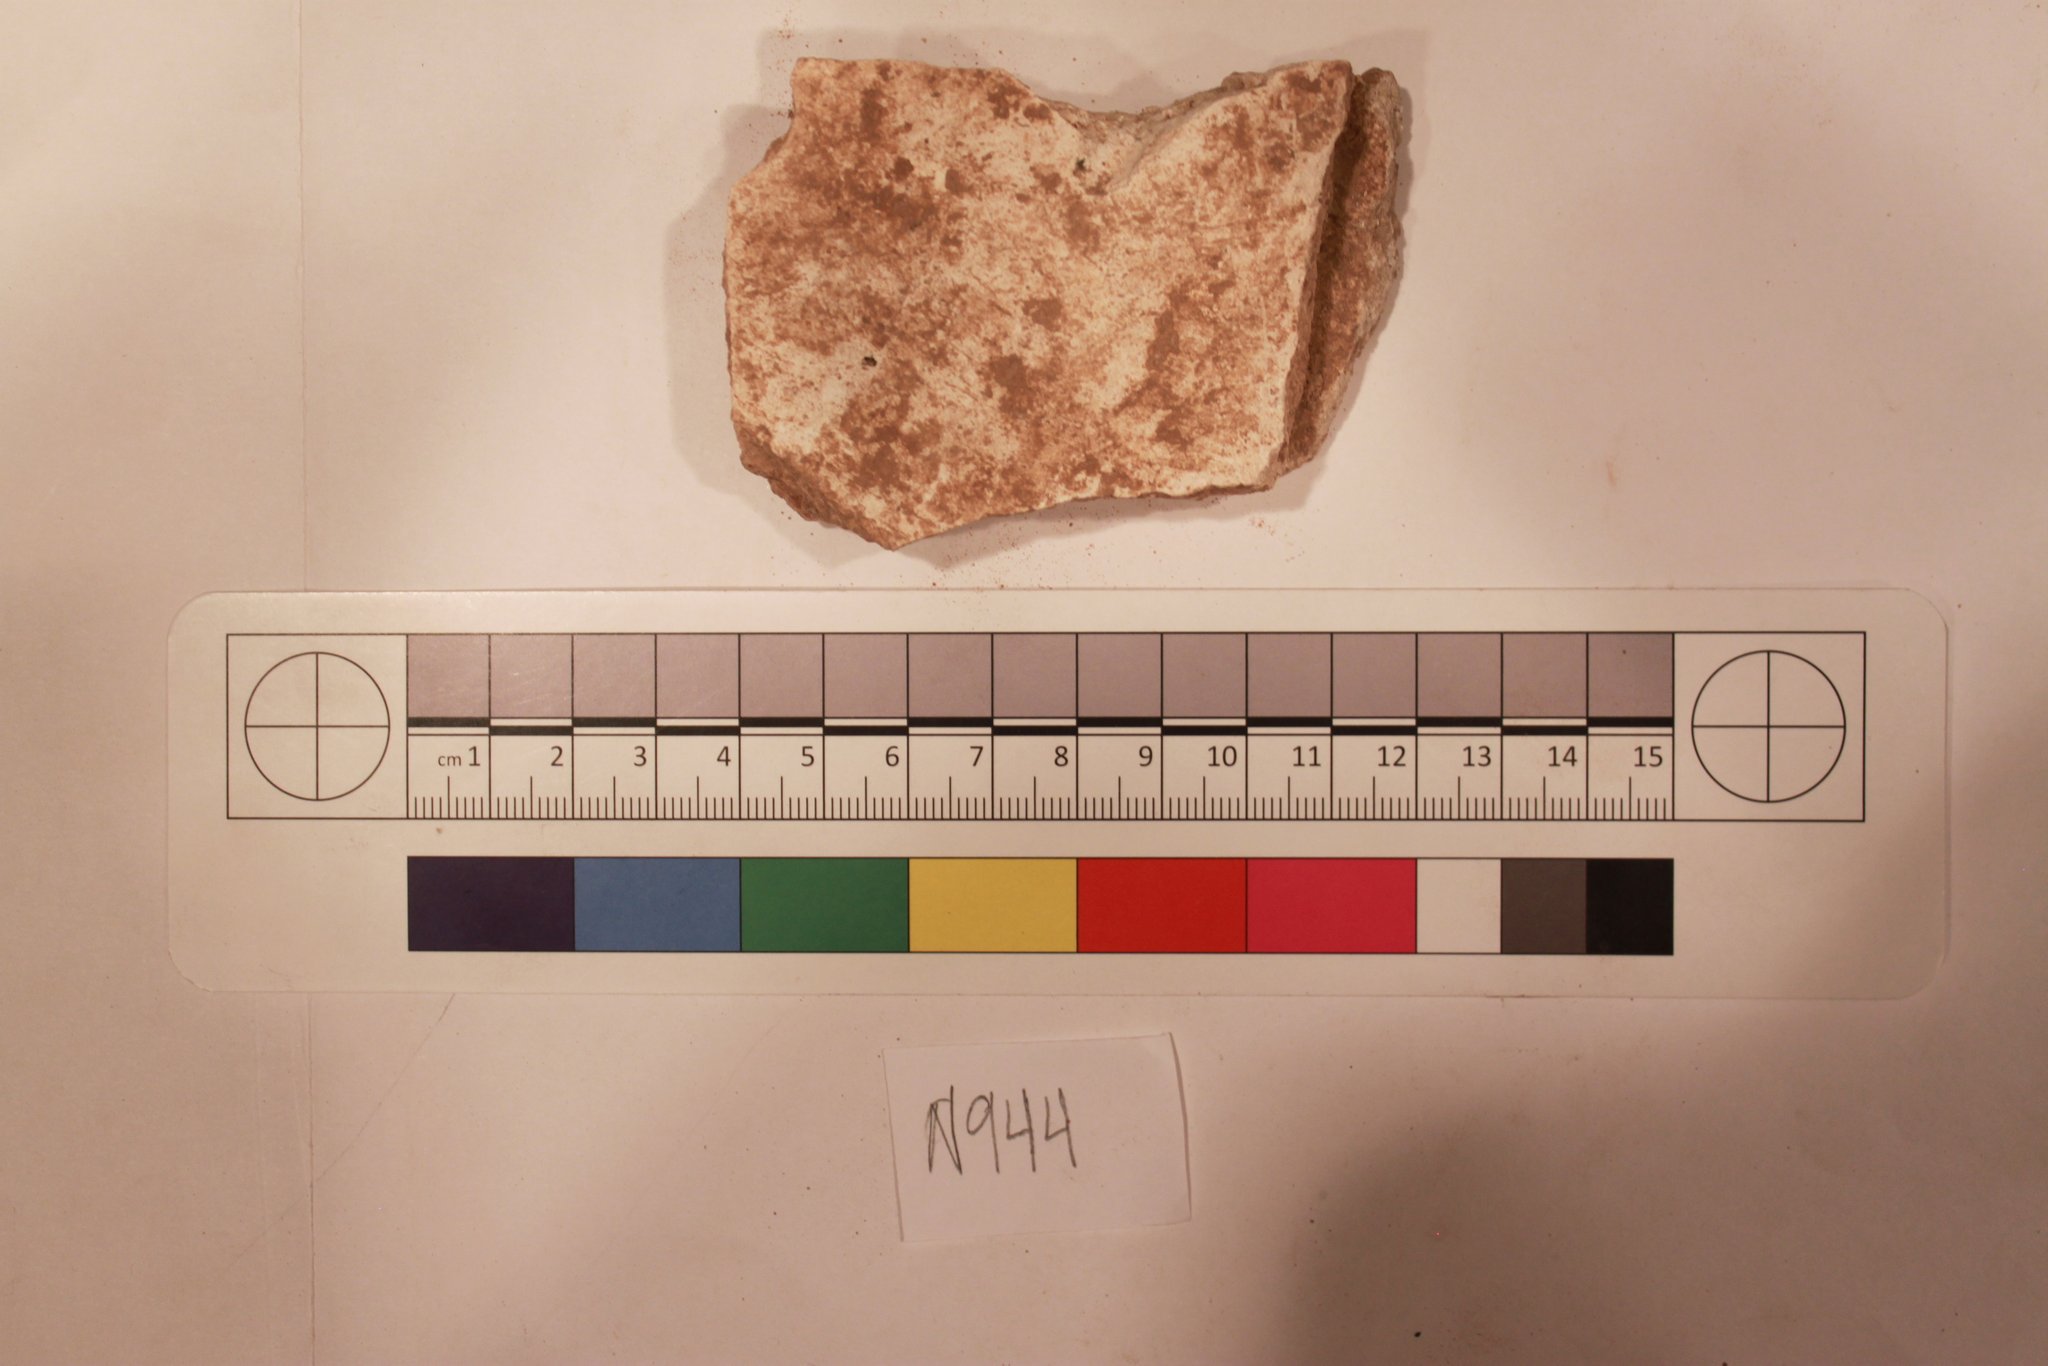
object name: fragment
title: Stucco Fragment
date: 701-1200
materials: plaster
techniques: carving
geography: iran